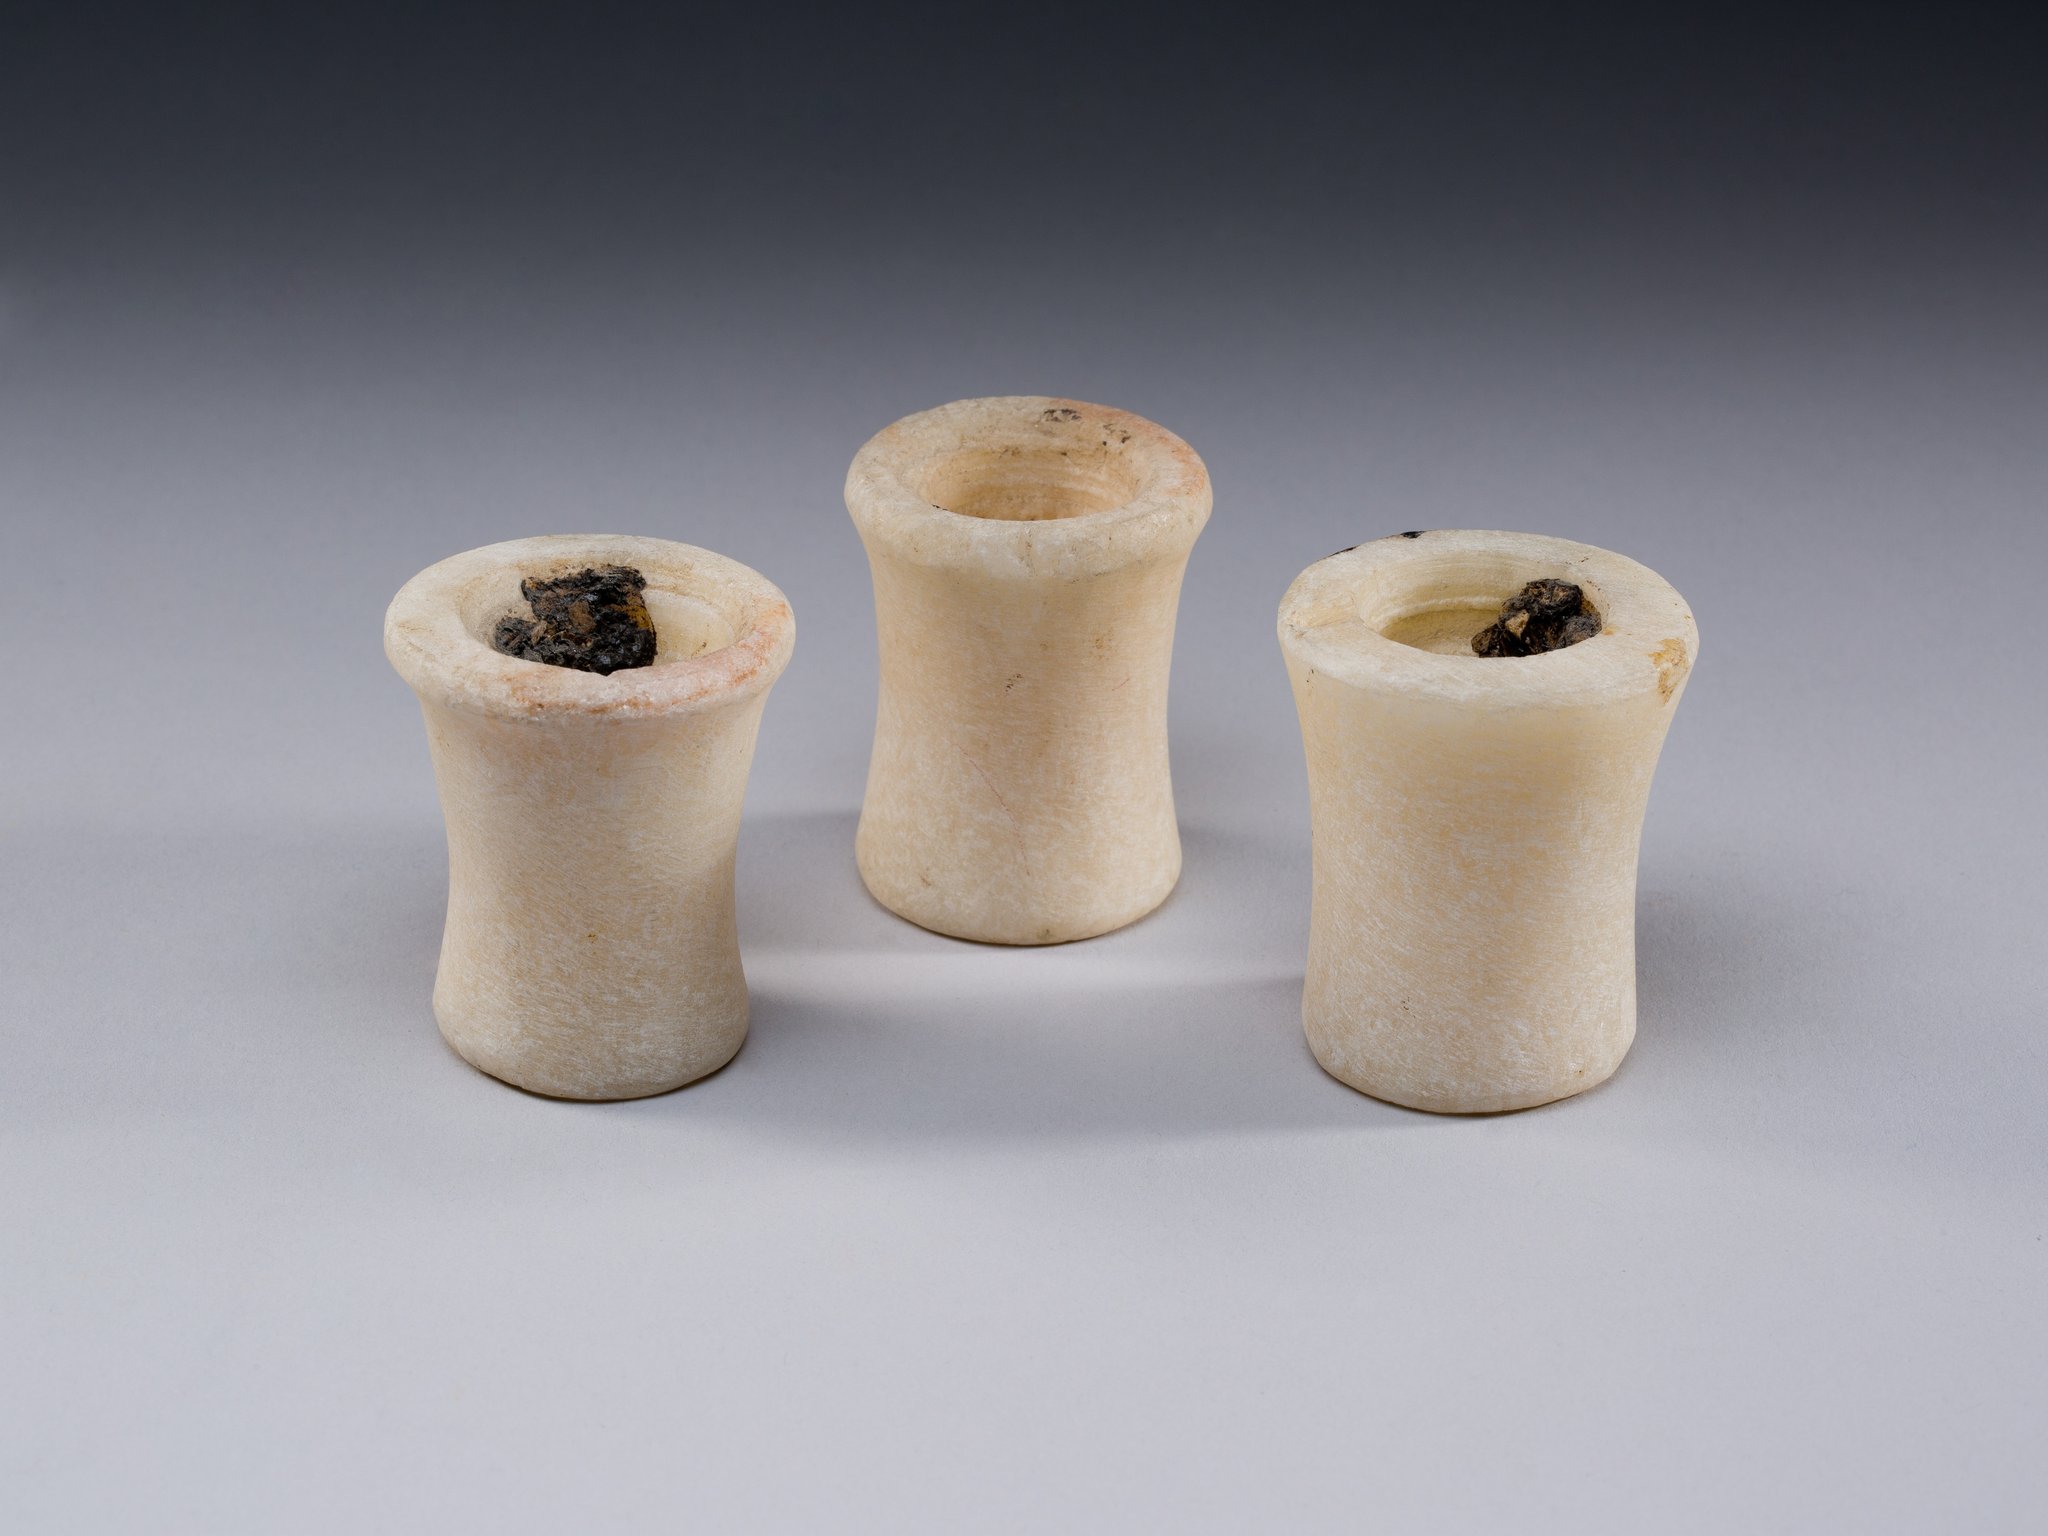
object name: ointment jar, model, senenmut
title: Model Ointment Jar from a Foundation Deposit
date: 1479-1458 BCE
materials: stone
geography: egypt